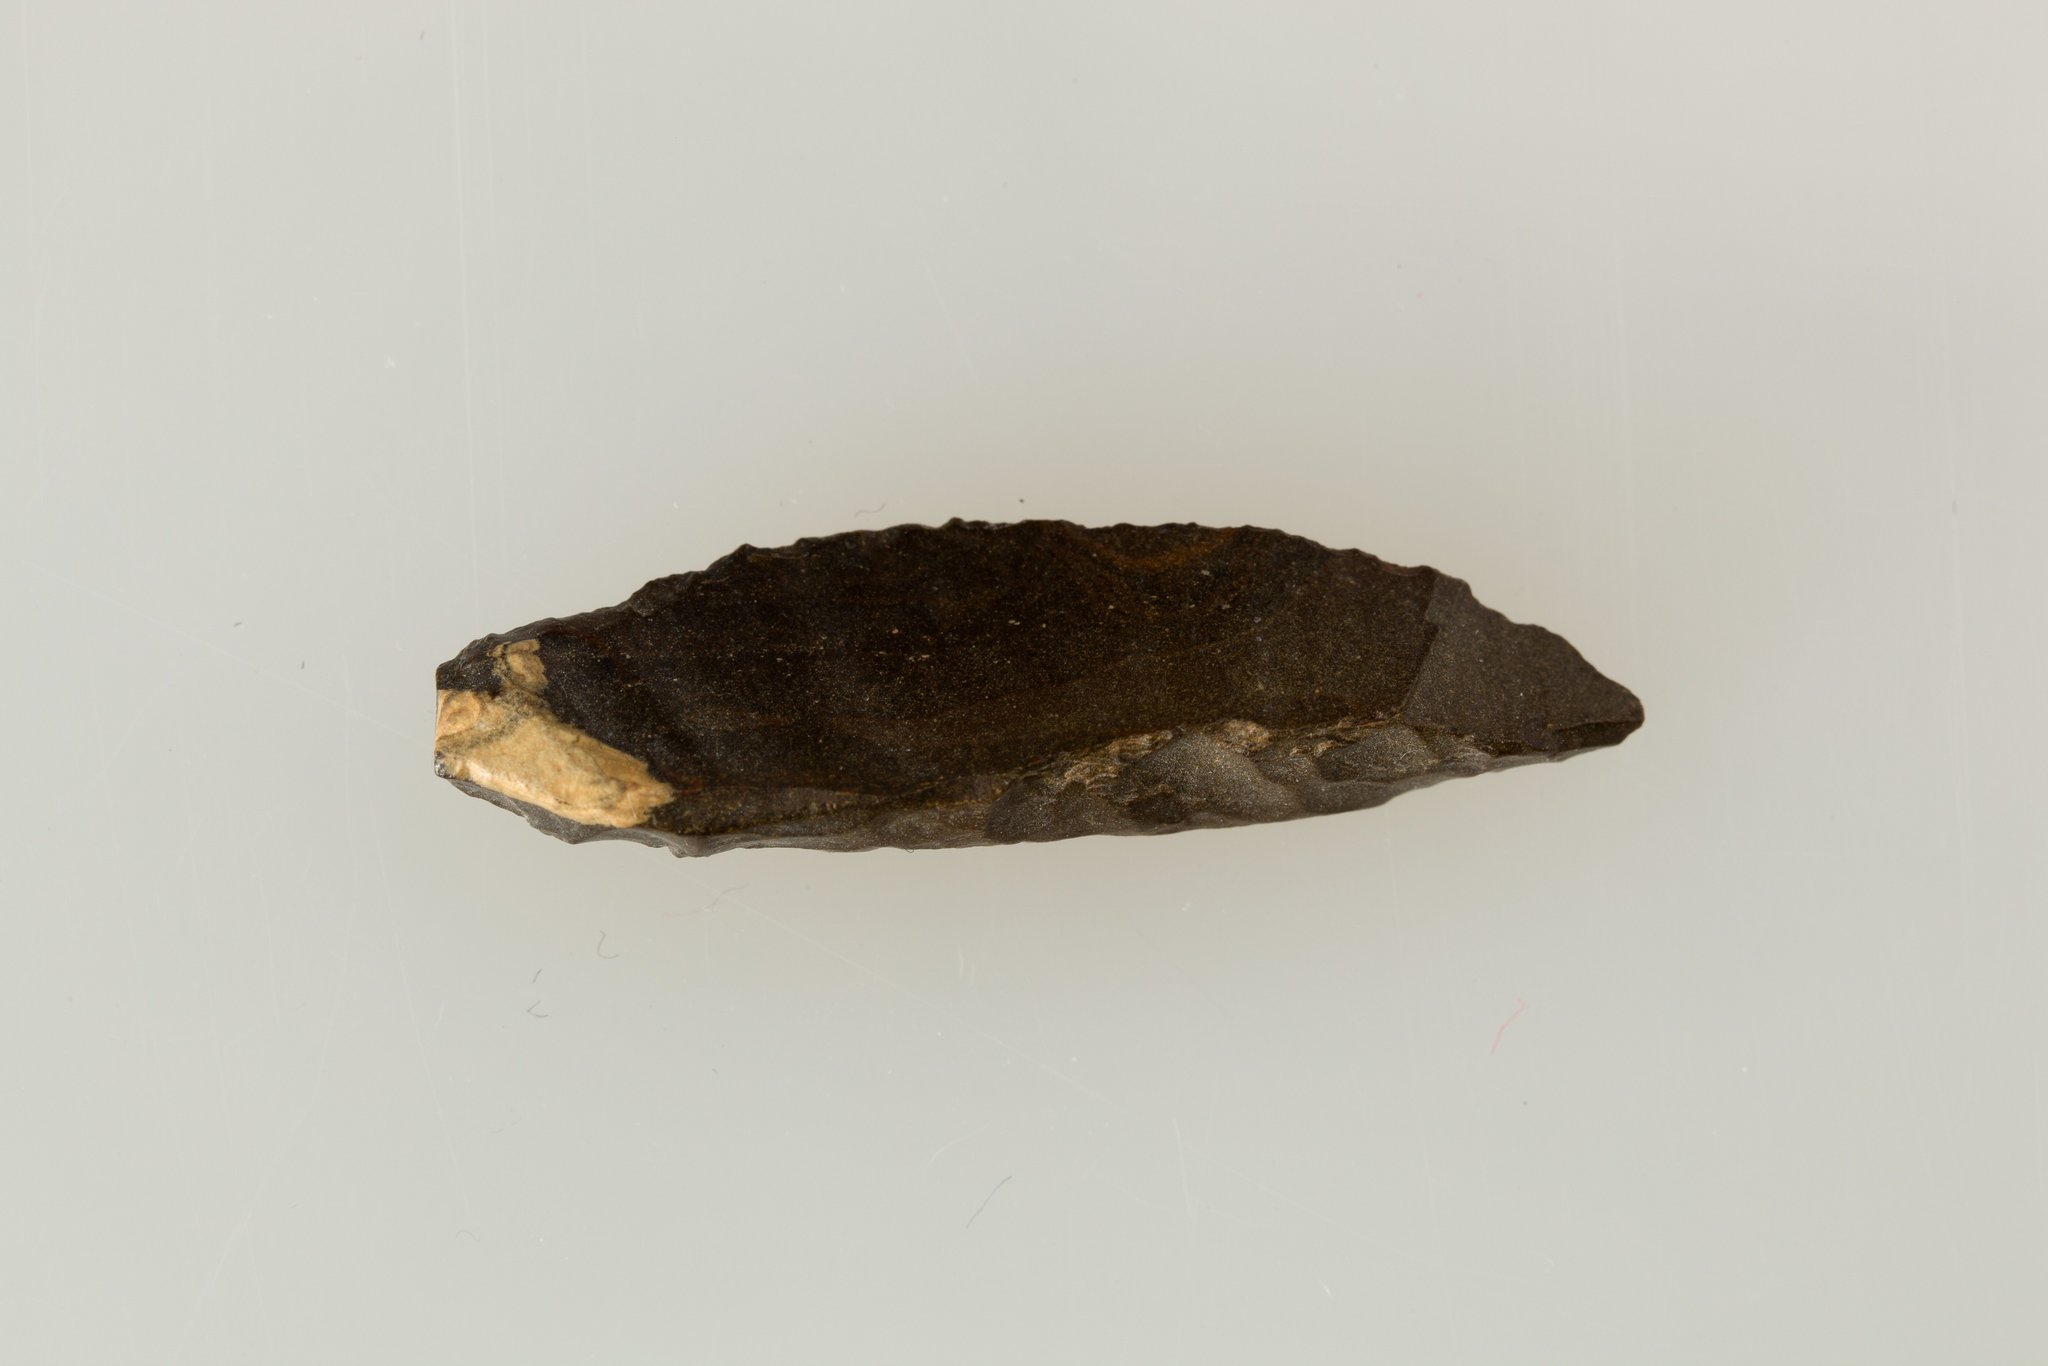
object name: tool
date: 3850-2960 BCE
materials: stone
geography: egypt